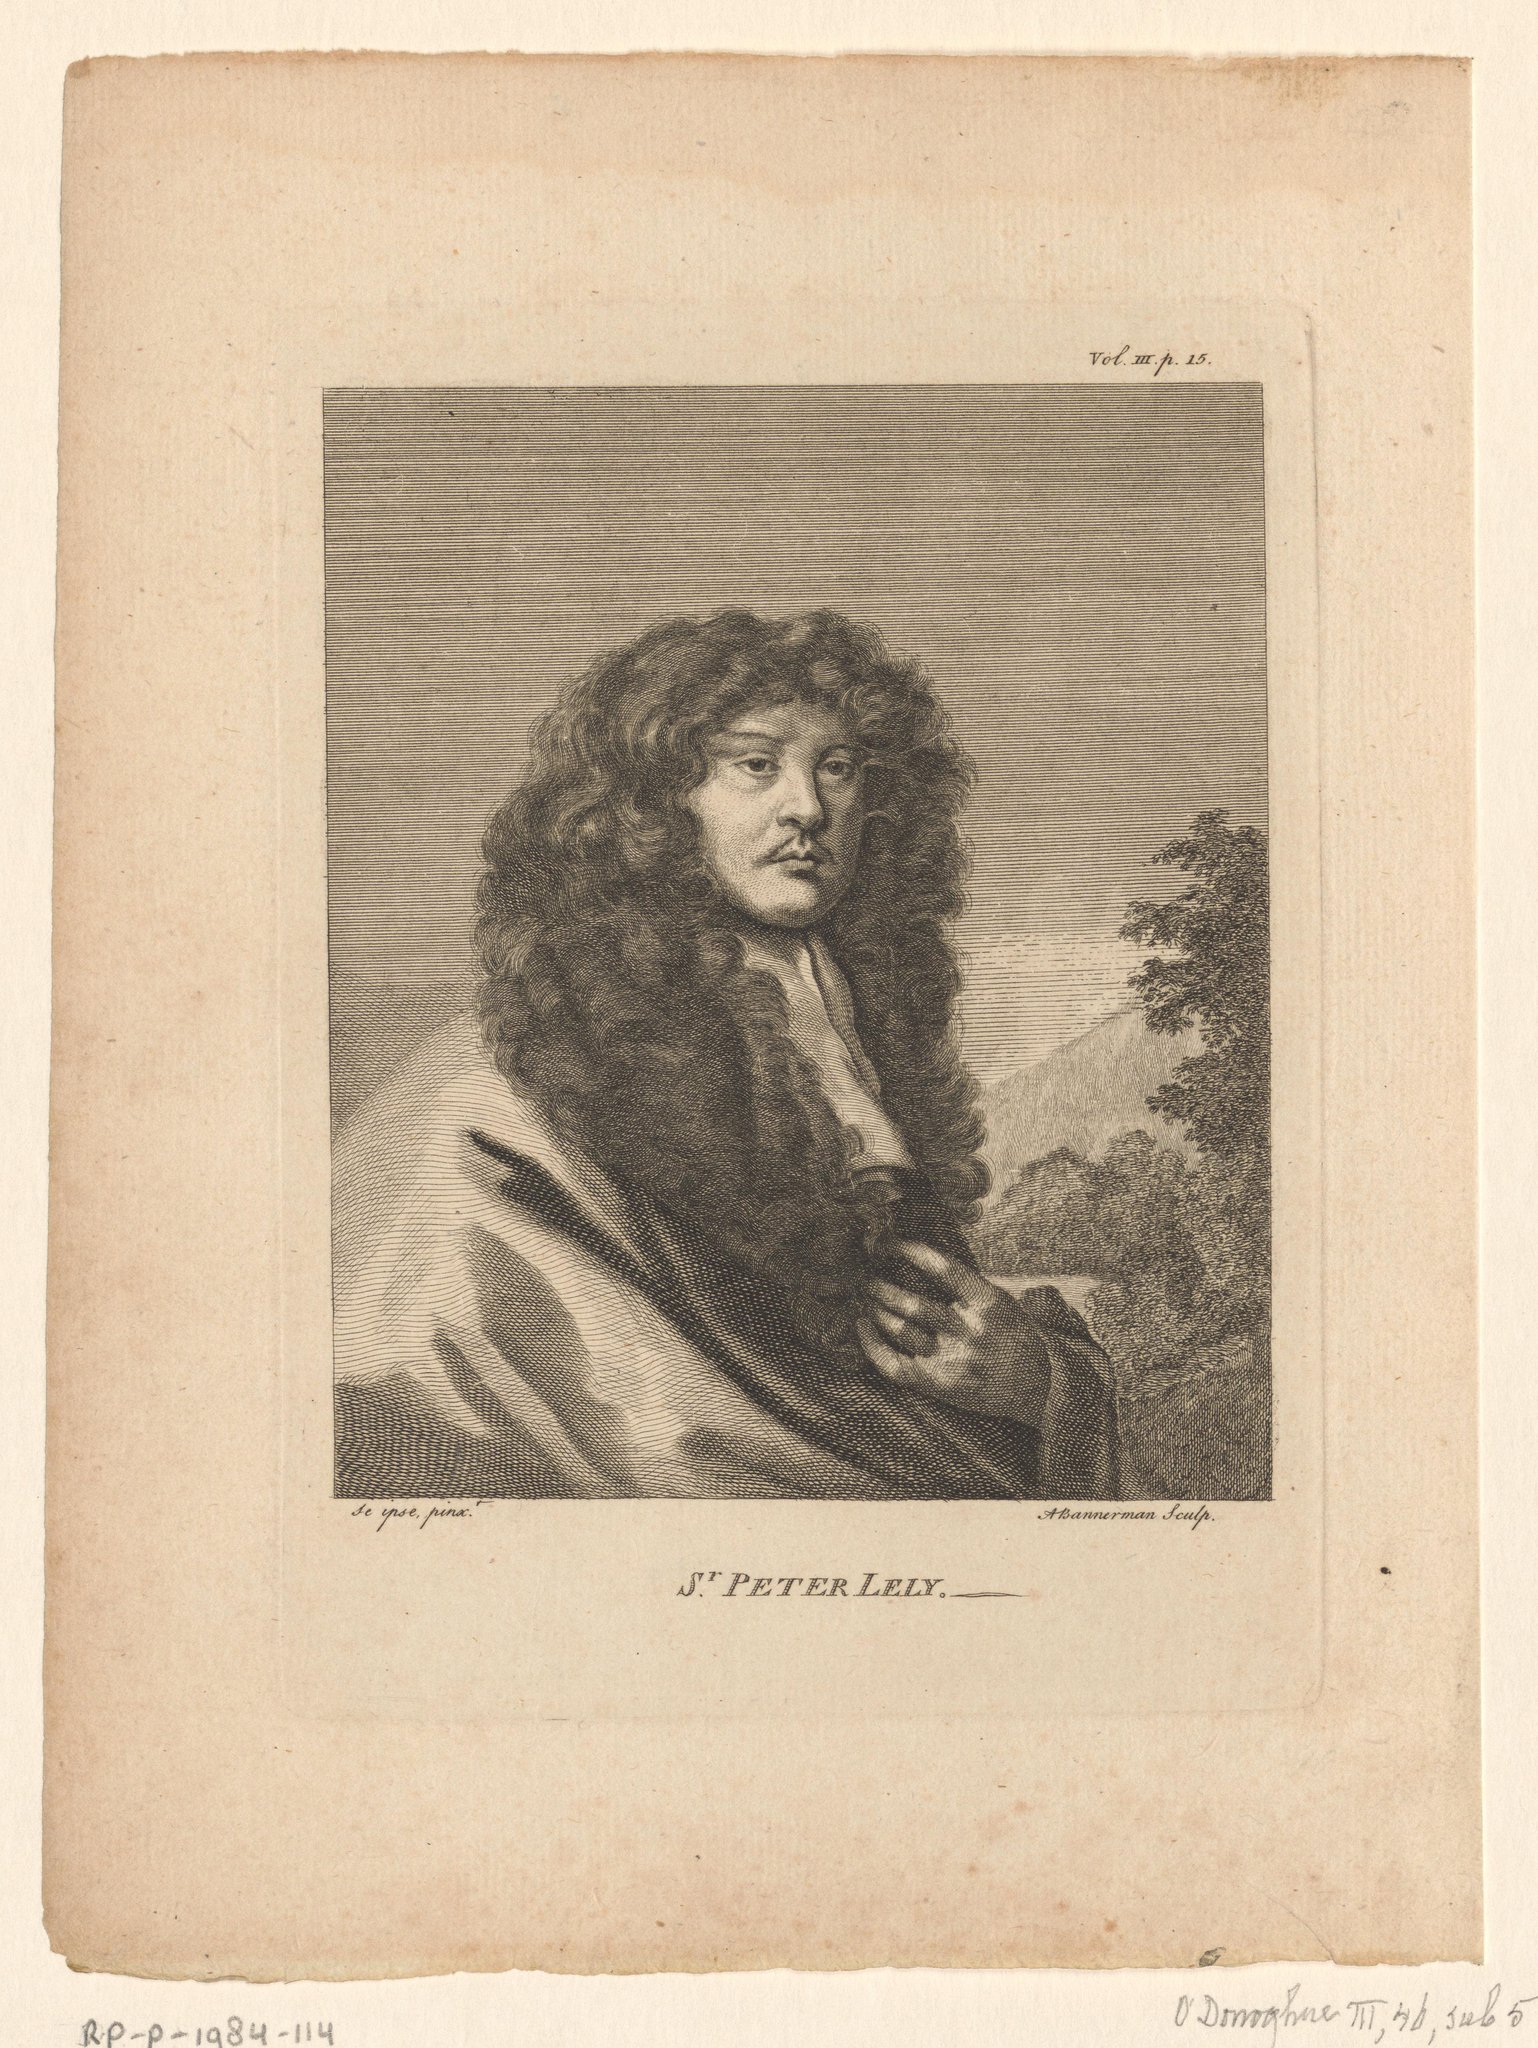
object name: book illustration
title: Portret van Peter Lely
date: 1763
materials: paper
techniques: engraving, etching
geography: london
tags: london, painter, draughtsman, peter lely (sir), historical persons, portrait, self-portrait of painter, mountains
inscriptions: collector's mark: Lugt 2228, collector's mark: Lugt 2760